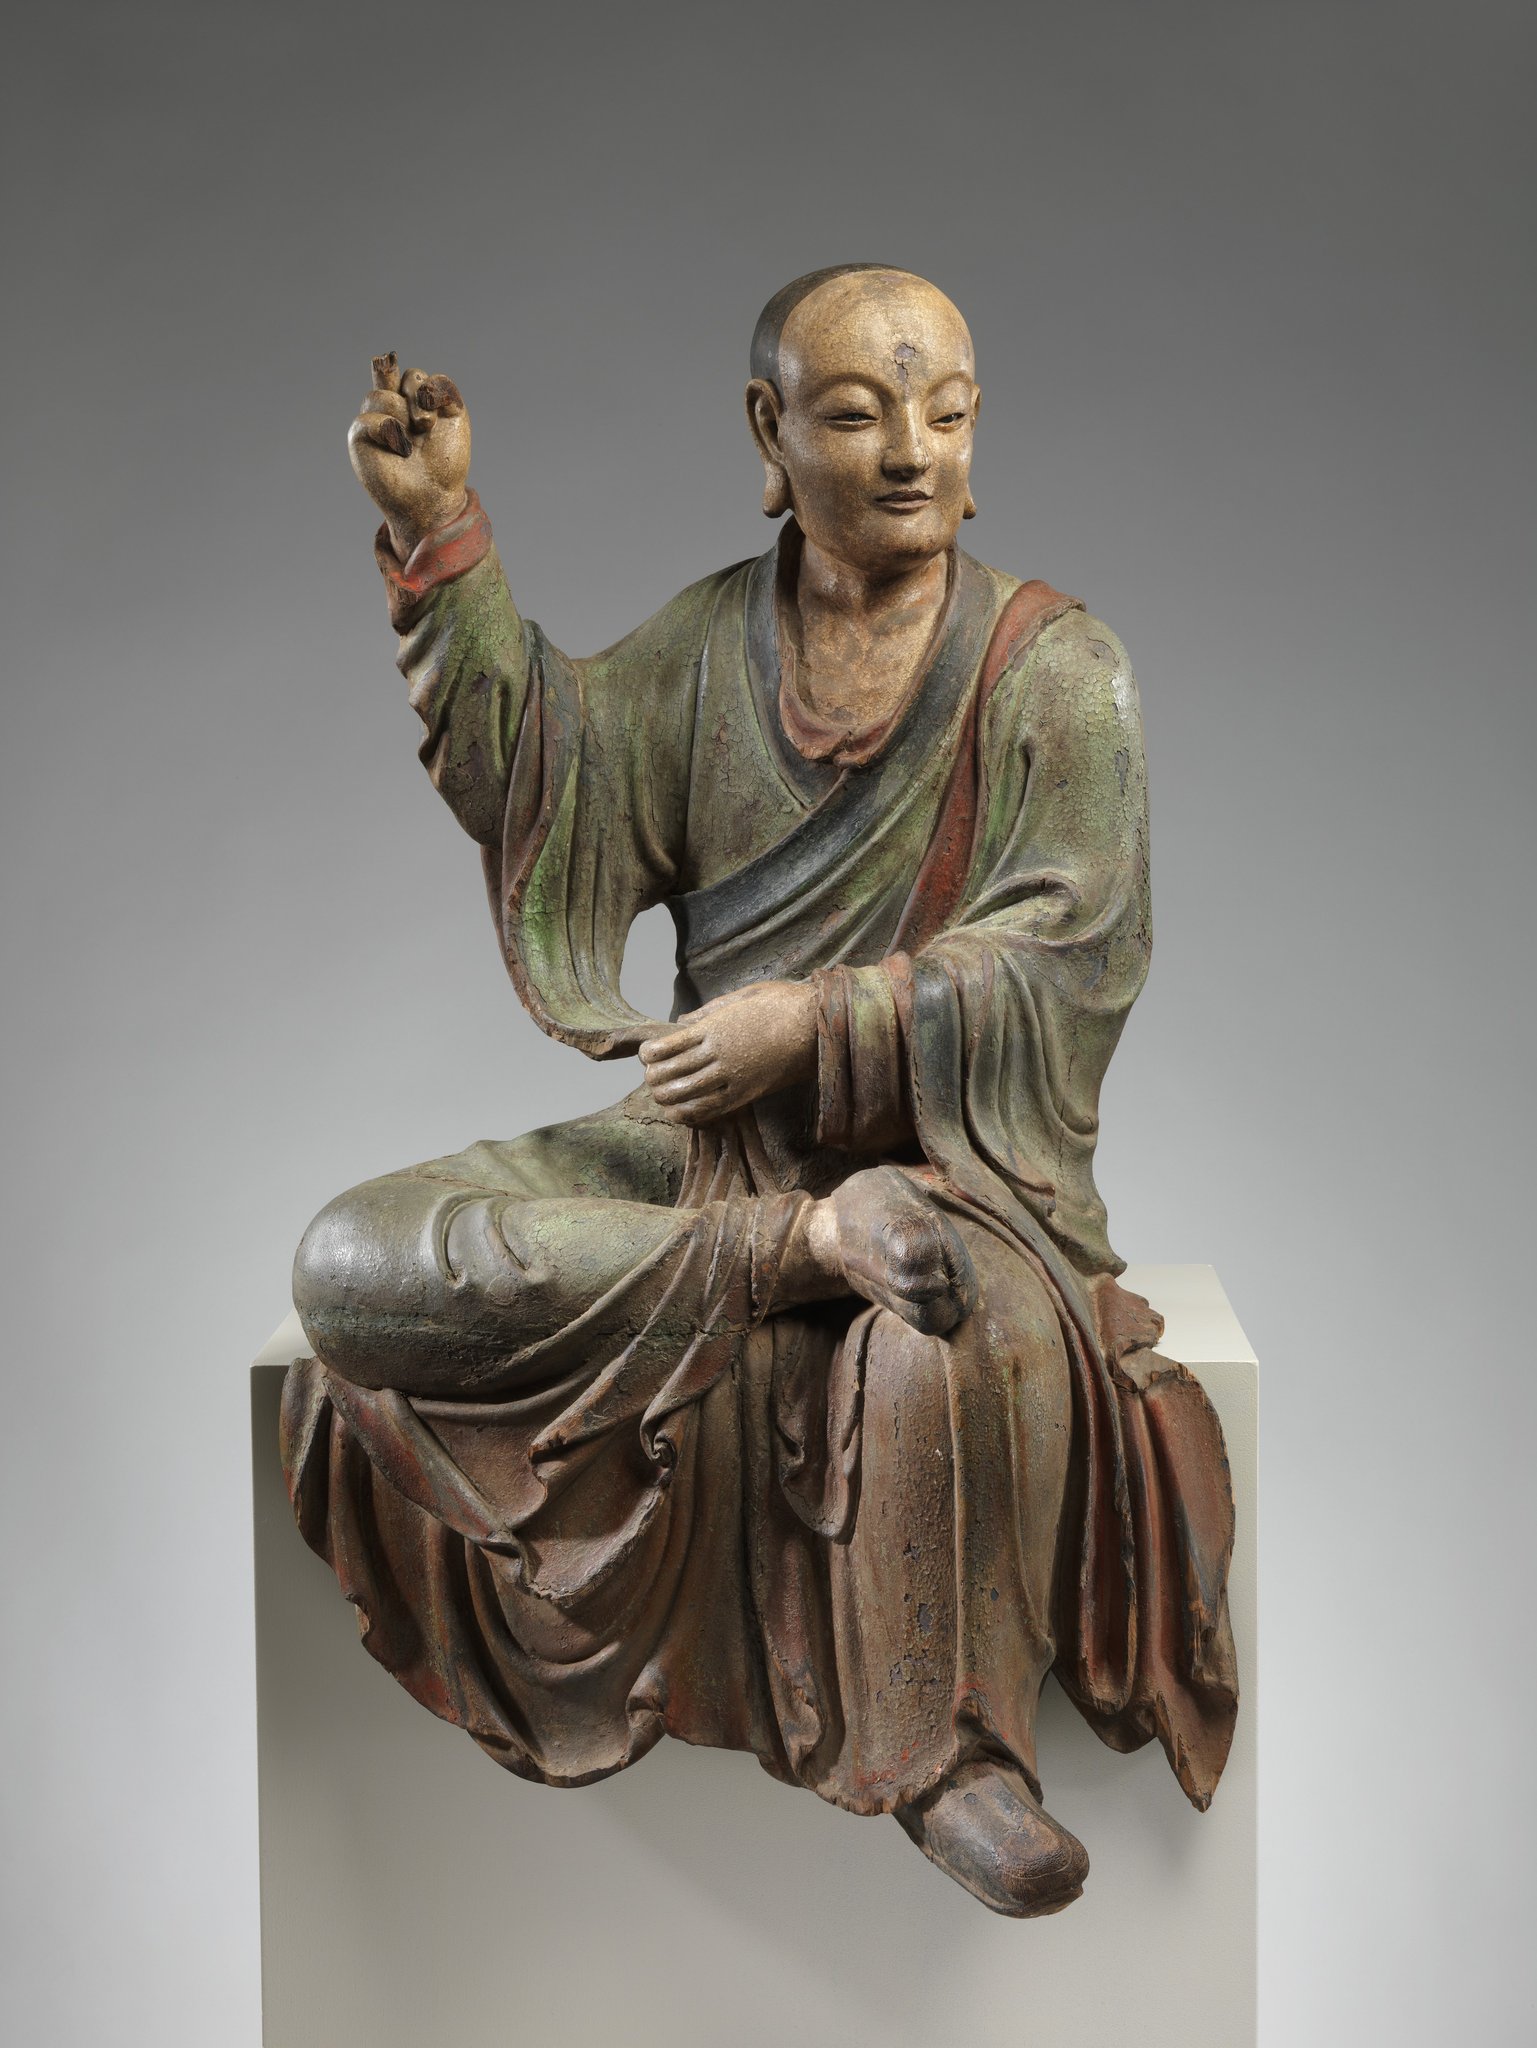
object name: figure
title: Arhat (Luohan)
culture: chinese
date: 1867-1900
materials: pigment, wood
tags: men,buddhism